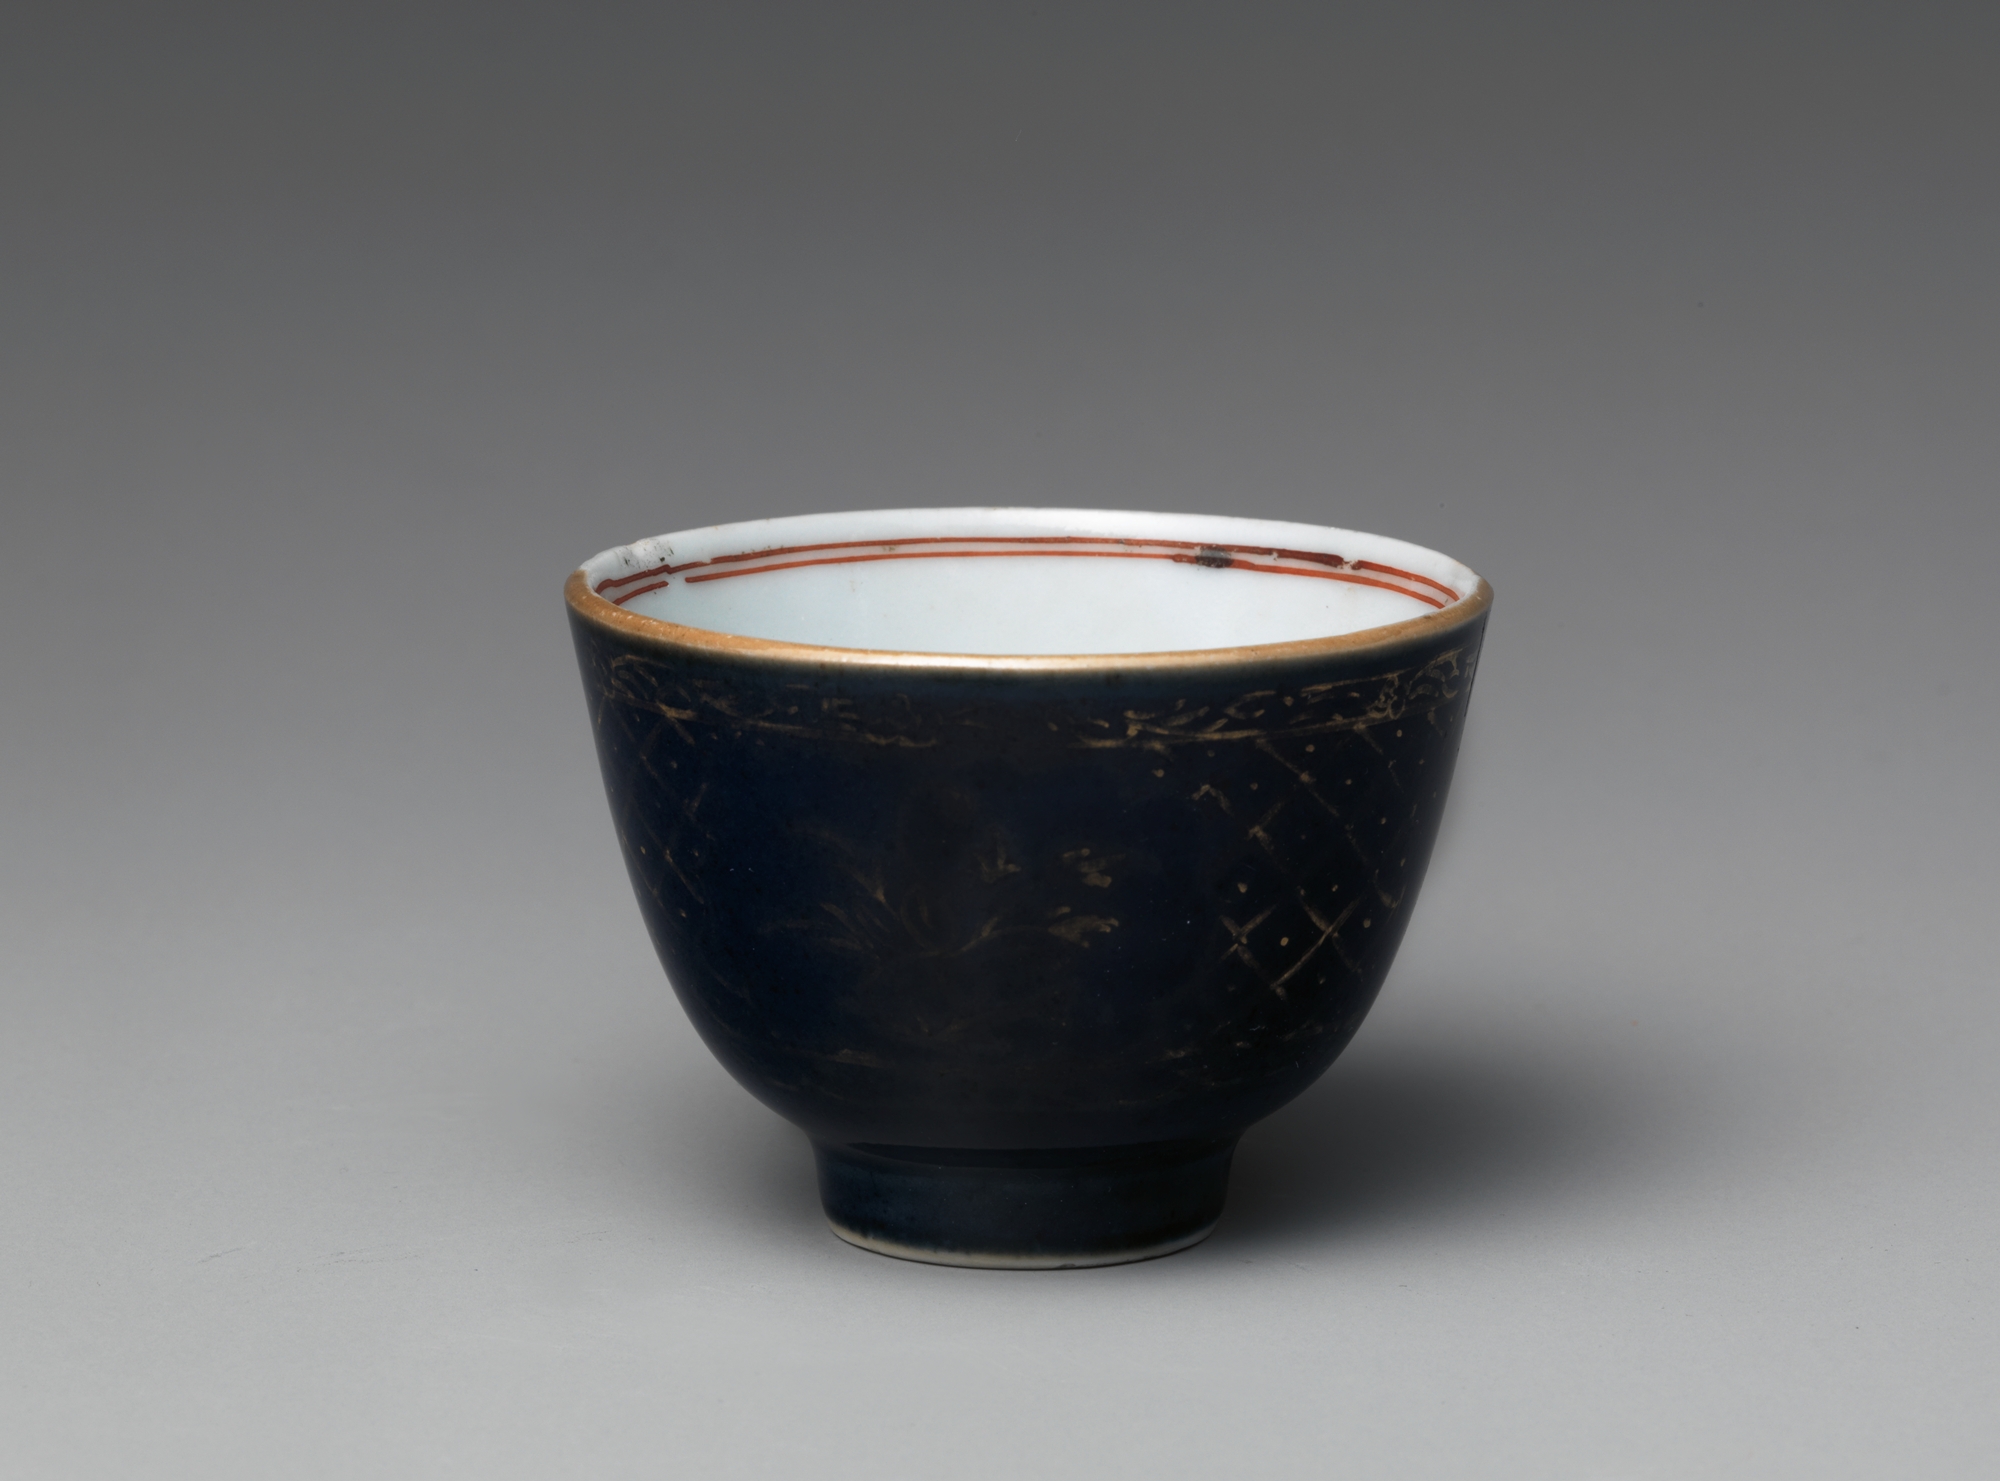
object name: cup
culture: chinese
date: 1736-1795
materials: porcelain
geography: china